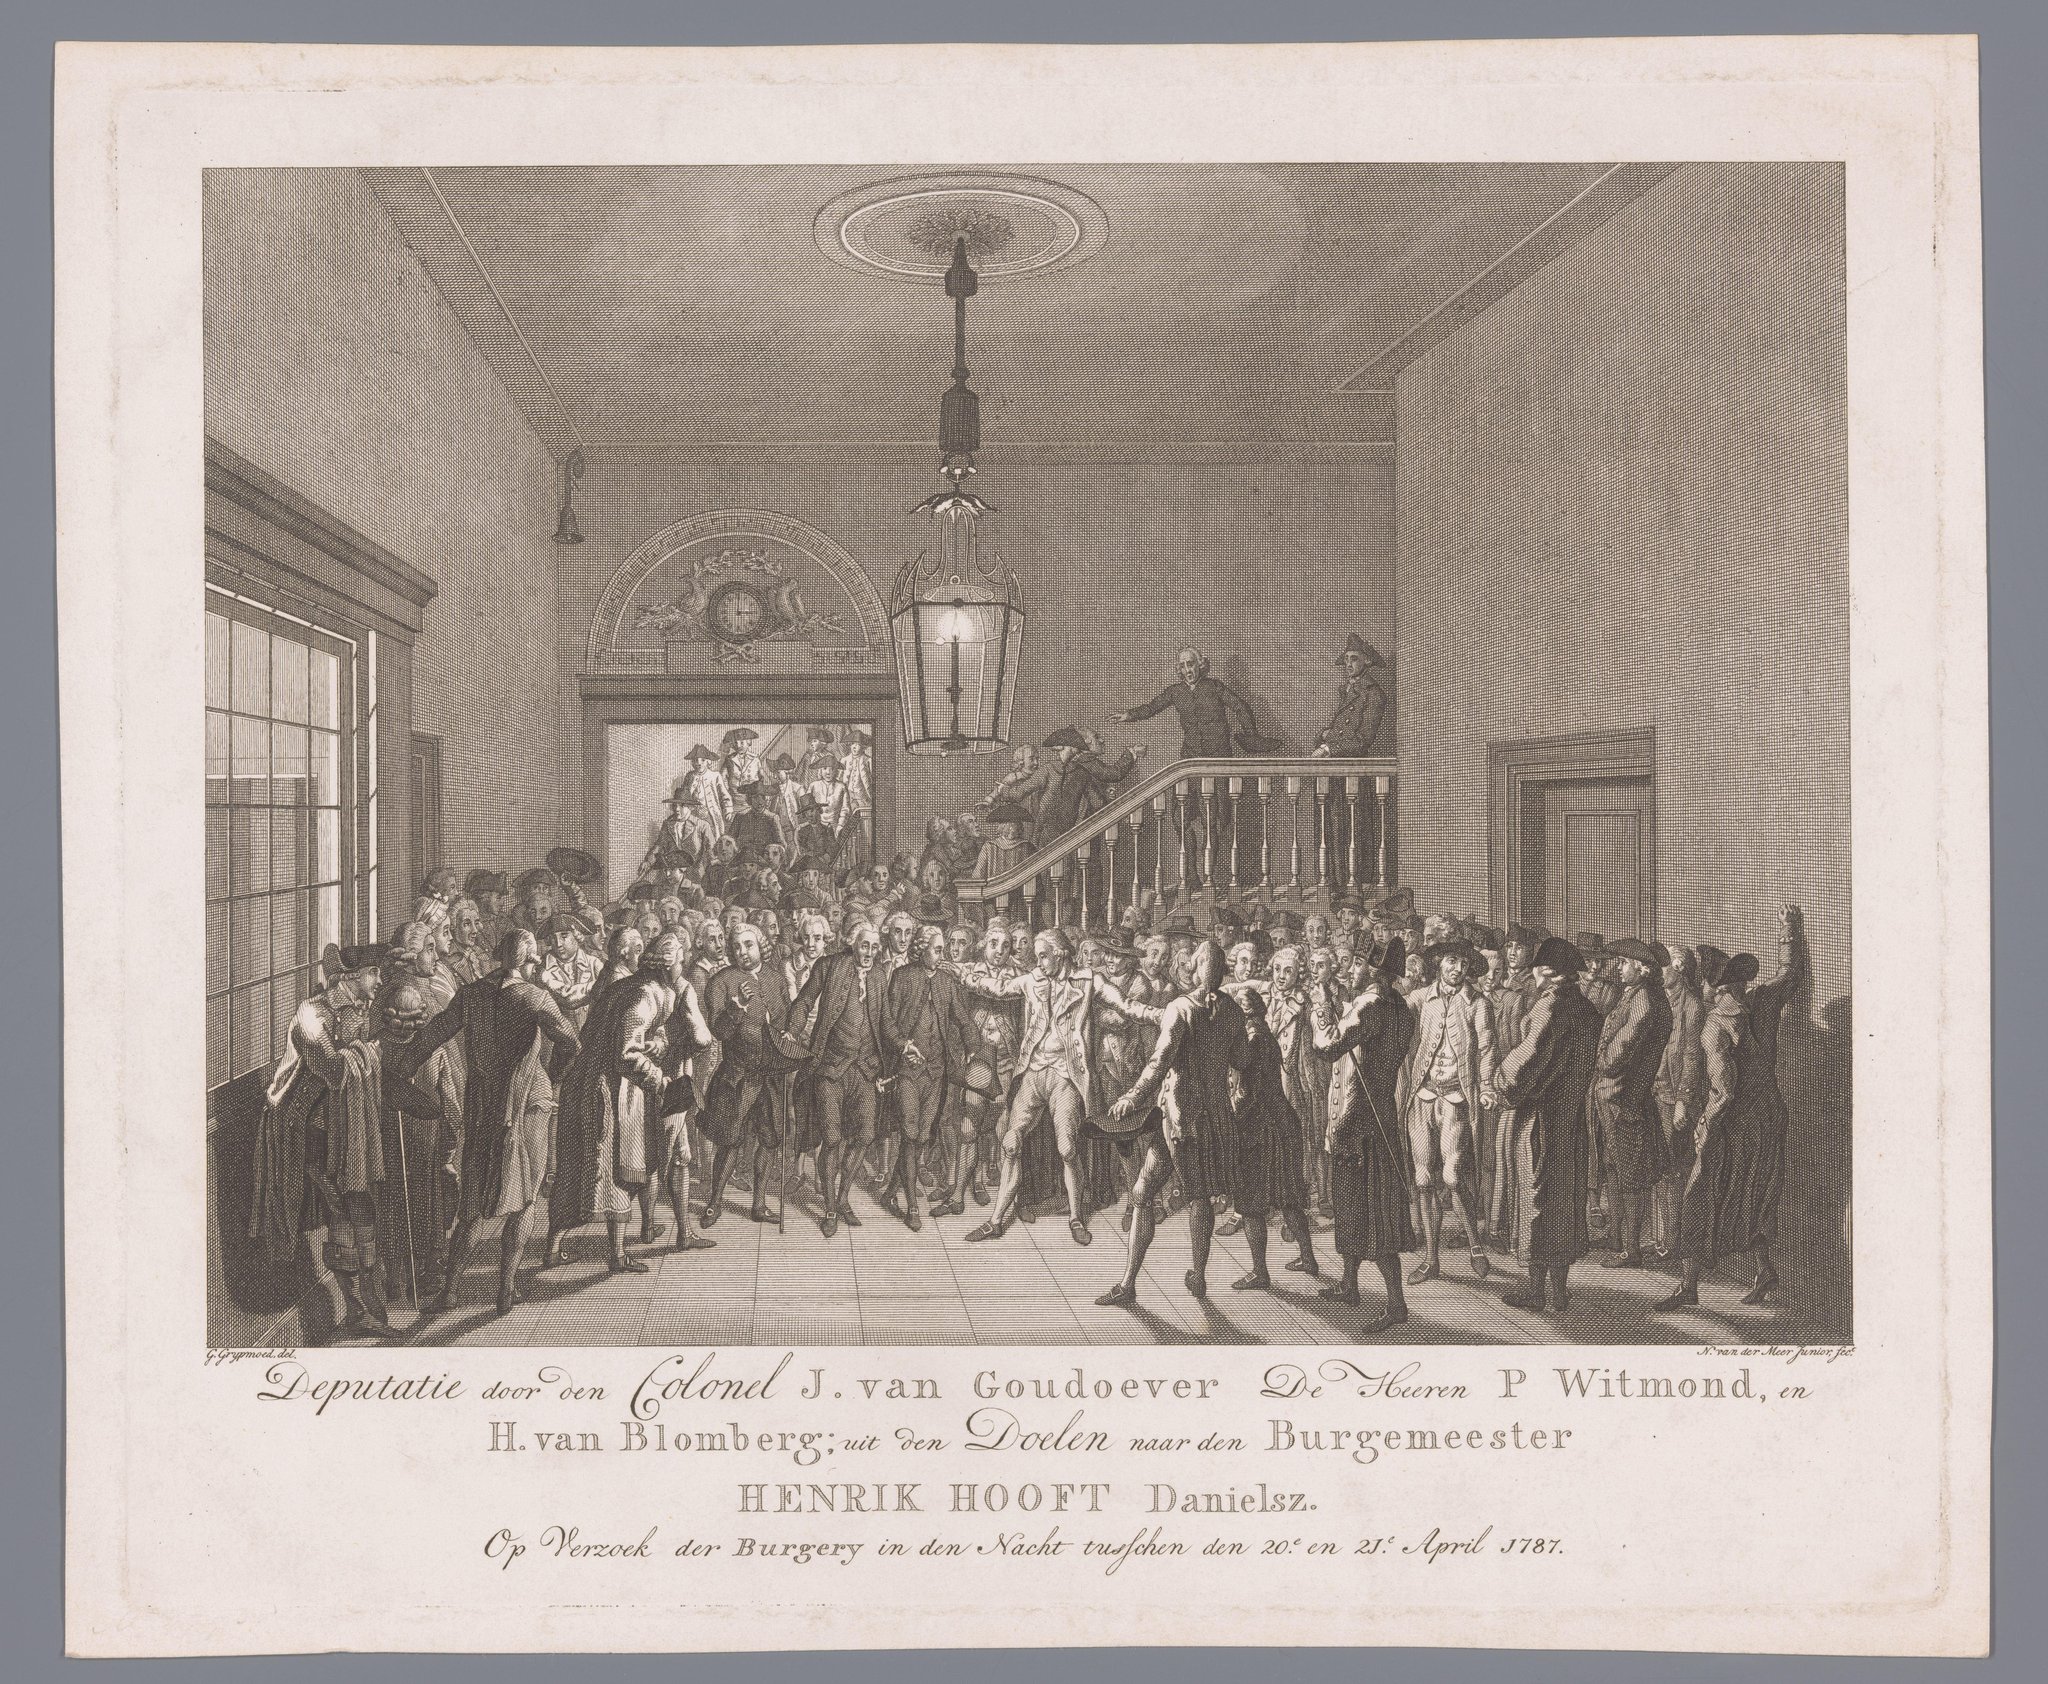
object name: print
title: Deputatie uit de Doelen naar burgemeester Hooft, 1787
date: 1787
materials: paper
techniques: engraving, etching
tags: mayor, hendrik danielsz. hooft, revolutionary council, patriots (1780-1795)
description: Een deputatie bestaande uit kolonel Isaak van Goudoever, Pieter Witmond en Hendrik van Blomberg vanuit de Garnalendoelen naar burgemeester Hendrik Danielsz. Hooft met het verzoek namens de burgerij van Amsterdam om de remotie van negen raadsleden, in de nacht van 20 op 21 april 1787.